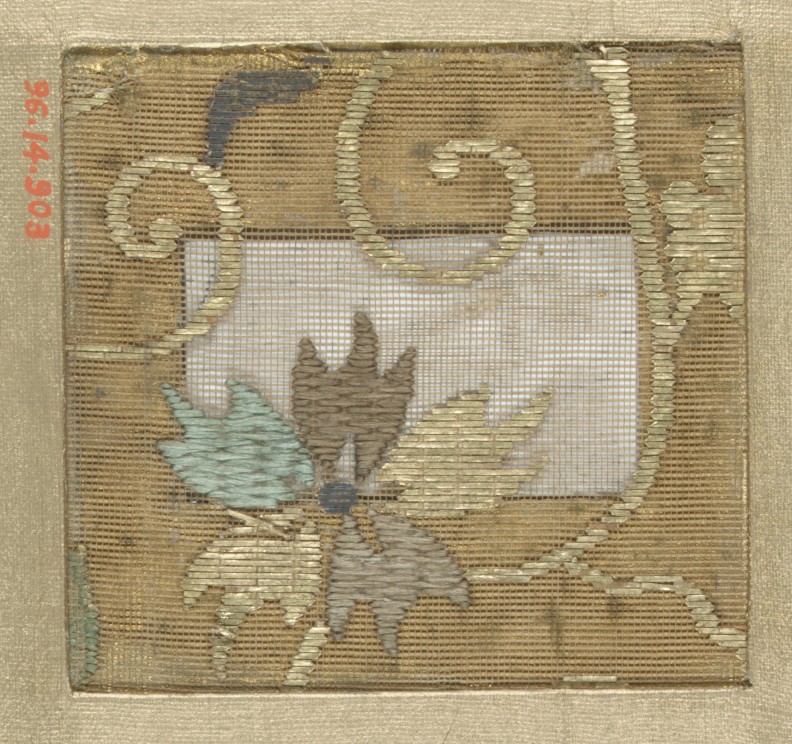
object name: piece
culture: japanese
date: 1101-1400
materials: metal thread, silk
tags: flowers